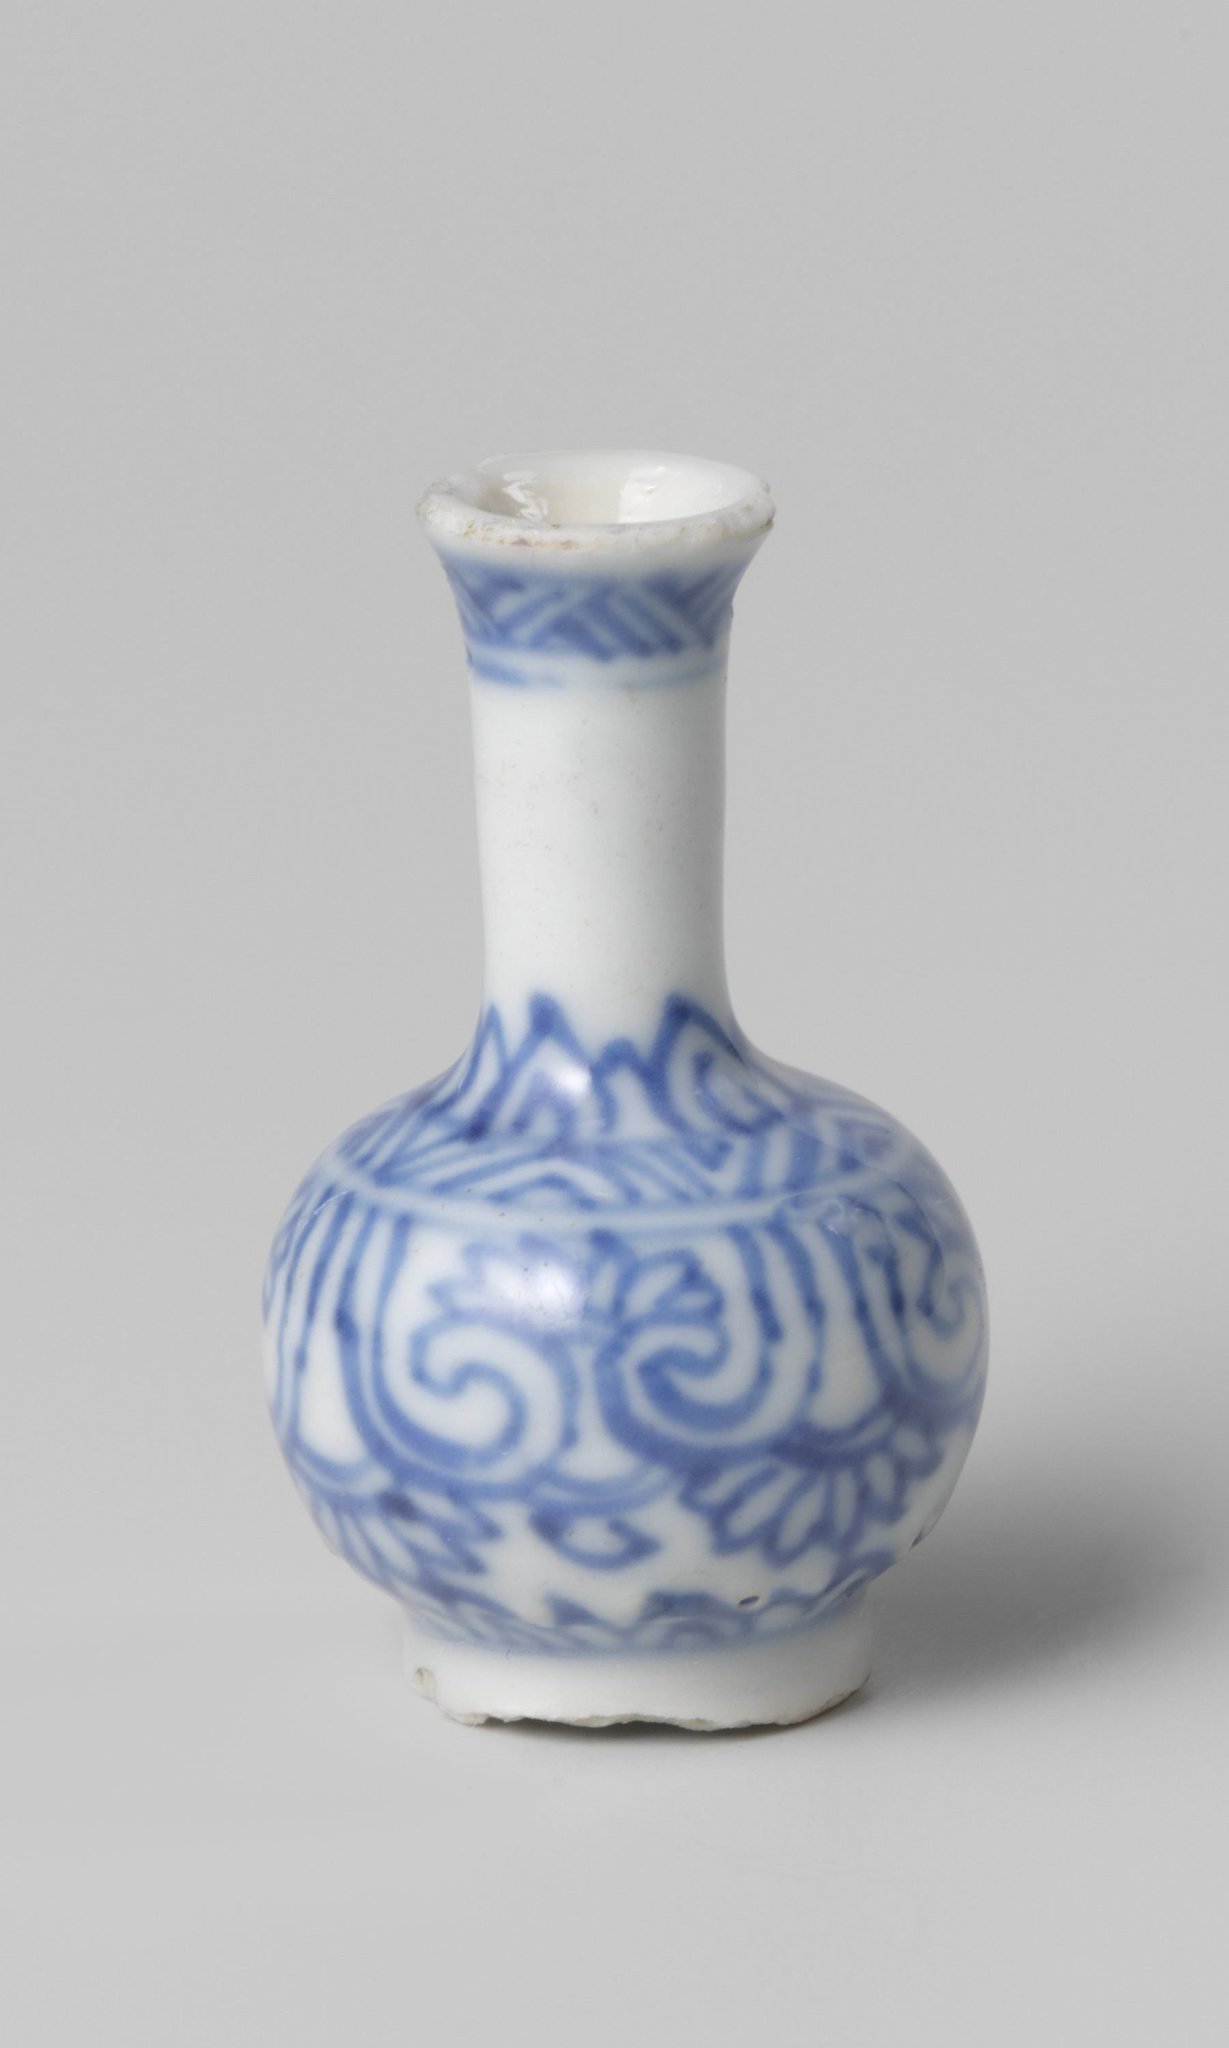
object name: vase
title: Miniature bottle vase with lotus scrolls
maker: Anonymous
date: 1675-1724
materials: cobalt, glaze, paint, porcelain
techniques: firing, turning, vitrification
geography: china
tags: ornament derived from plant forms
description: Miniatuur flesvormige vaas van porselein met een bolvormig lichaam en lange, smalle nek met iets spreidende mond, beschilderd in onderglazuur blauw. Op de buik lotusranken. De schouder met een band met een zigzag-patroon en bladmotieven. De rand met een zigag-patroon. Blauw-wit.